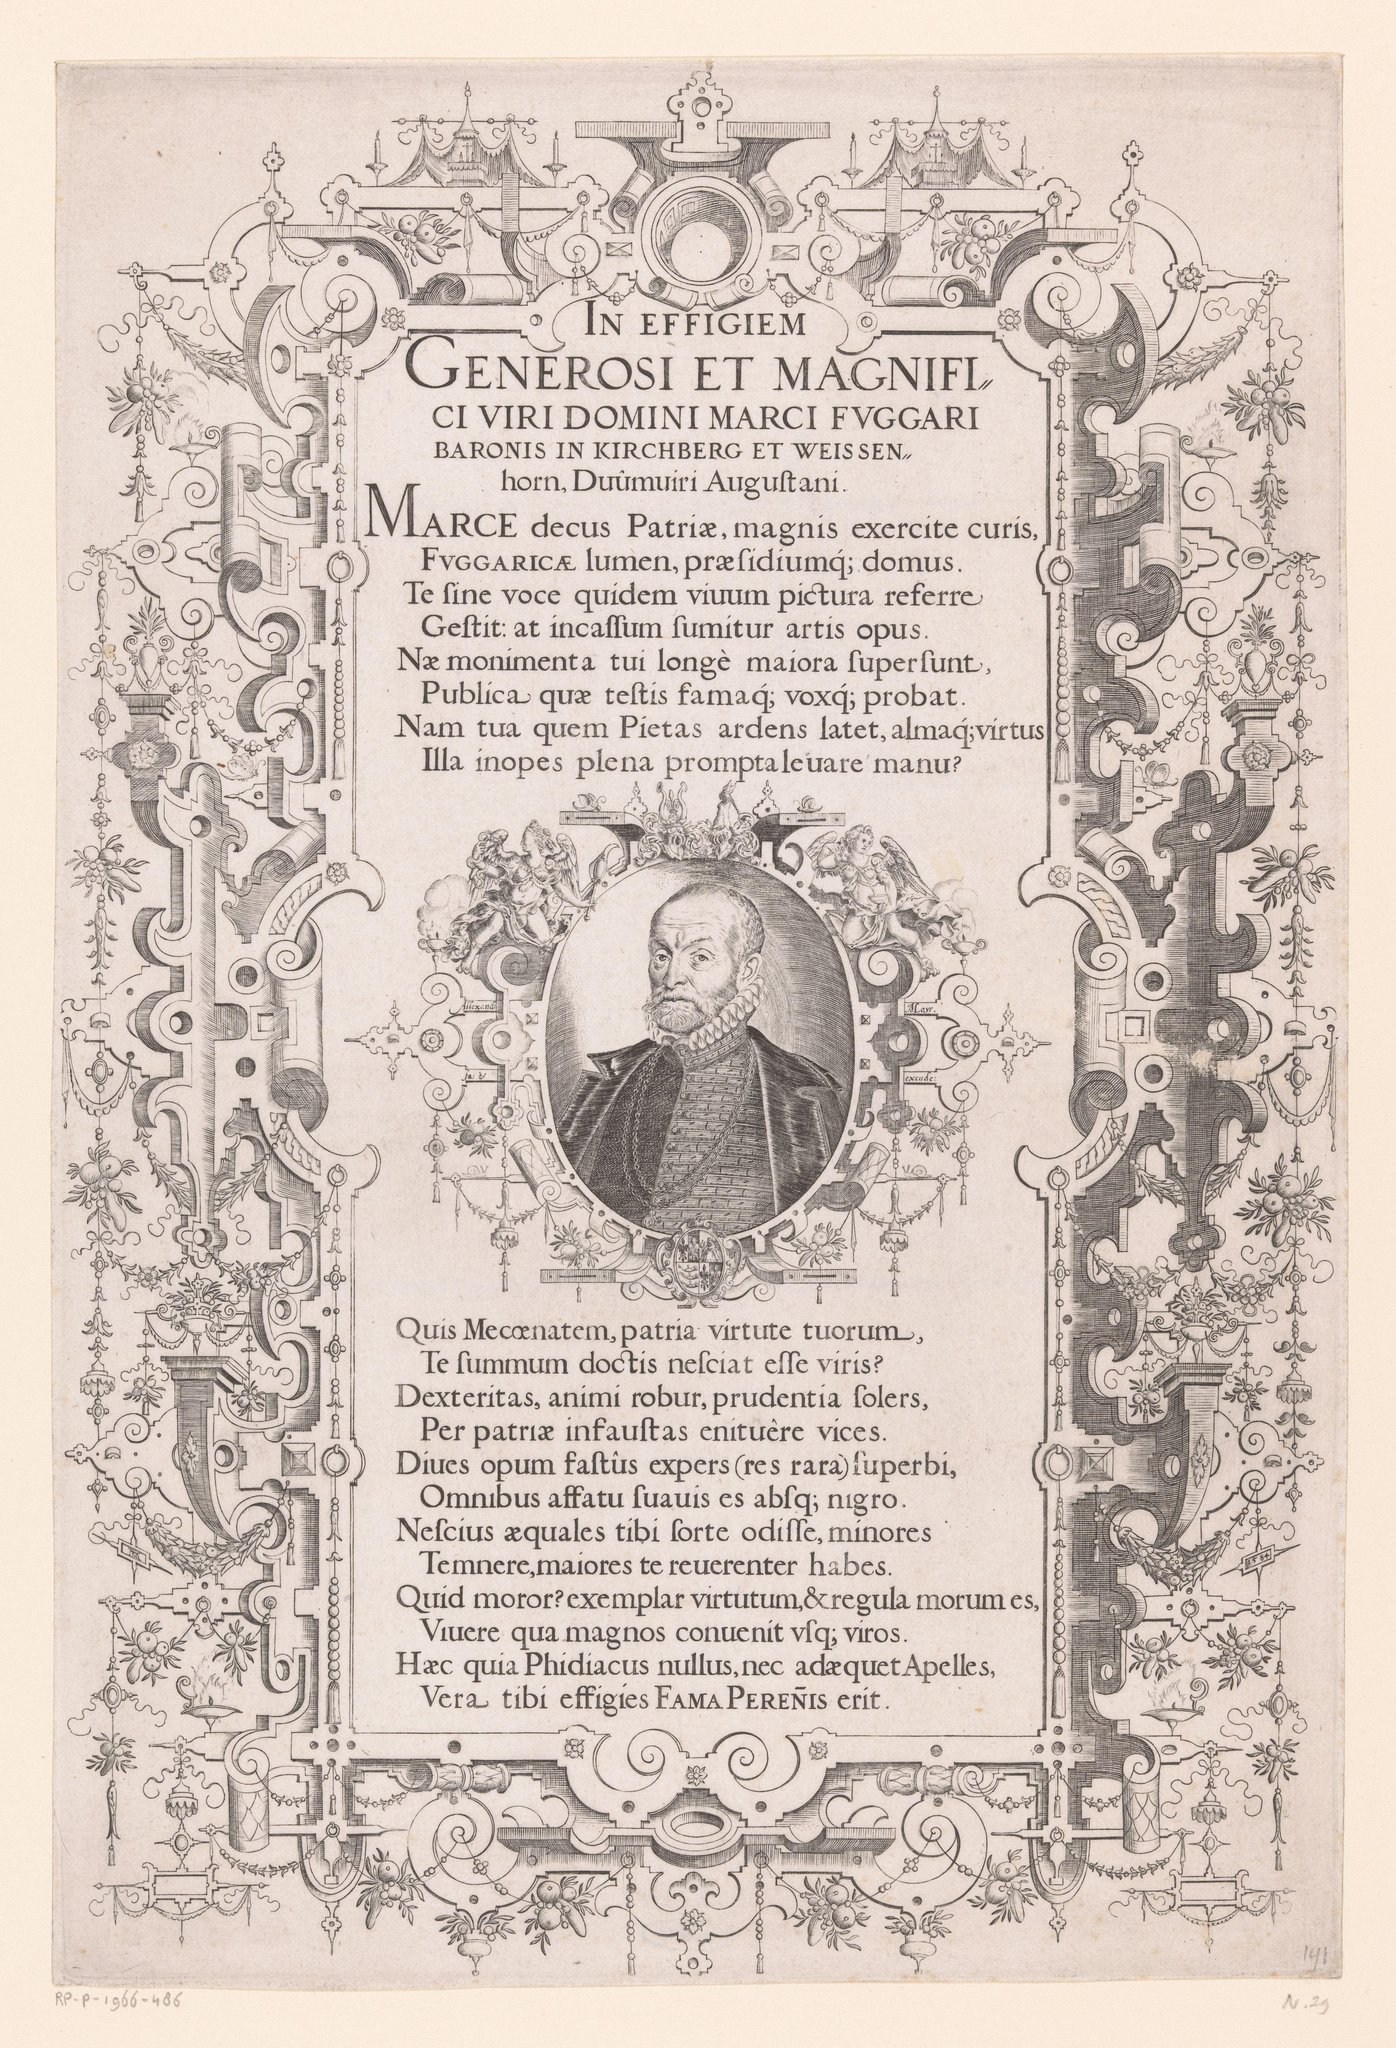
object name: print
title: Portret van Markus Fugger met ornamentrand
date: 1584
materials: paper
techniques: engraving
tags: augsburg, mayor, marcus fugger (baron van kirchberg en weissenhorn), scrollwork, strapwork ~ ornament, historical persons, ornament ~ cartouche, armorial bearing, heraldry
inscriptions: collector's mark: Lugt 2228